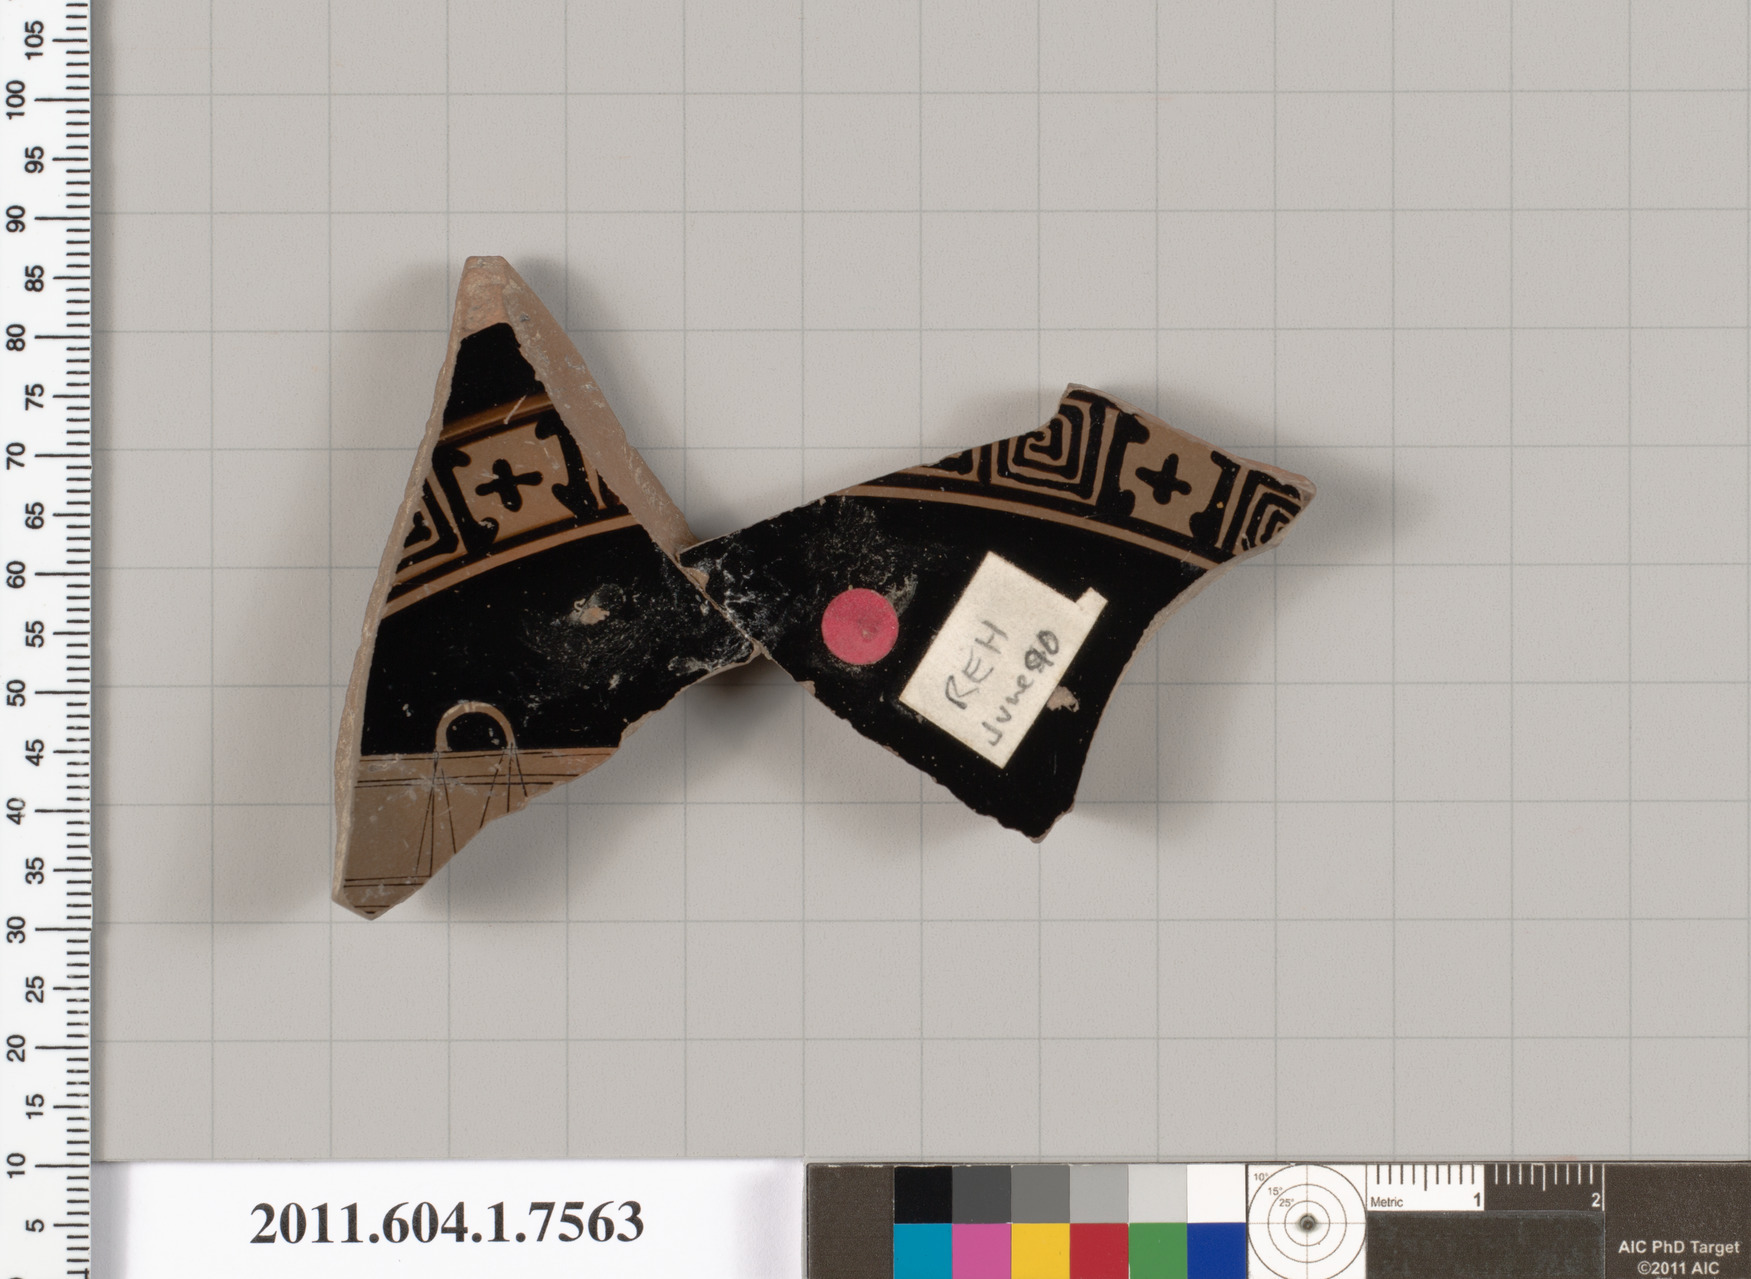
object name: kylix fragment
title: Terracotta fragment of a kylix (drinking cup)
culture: greek, attic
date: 460-450 BCE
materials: terracotta